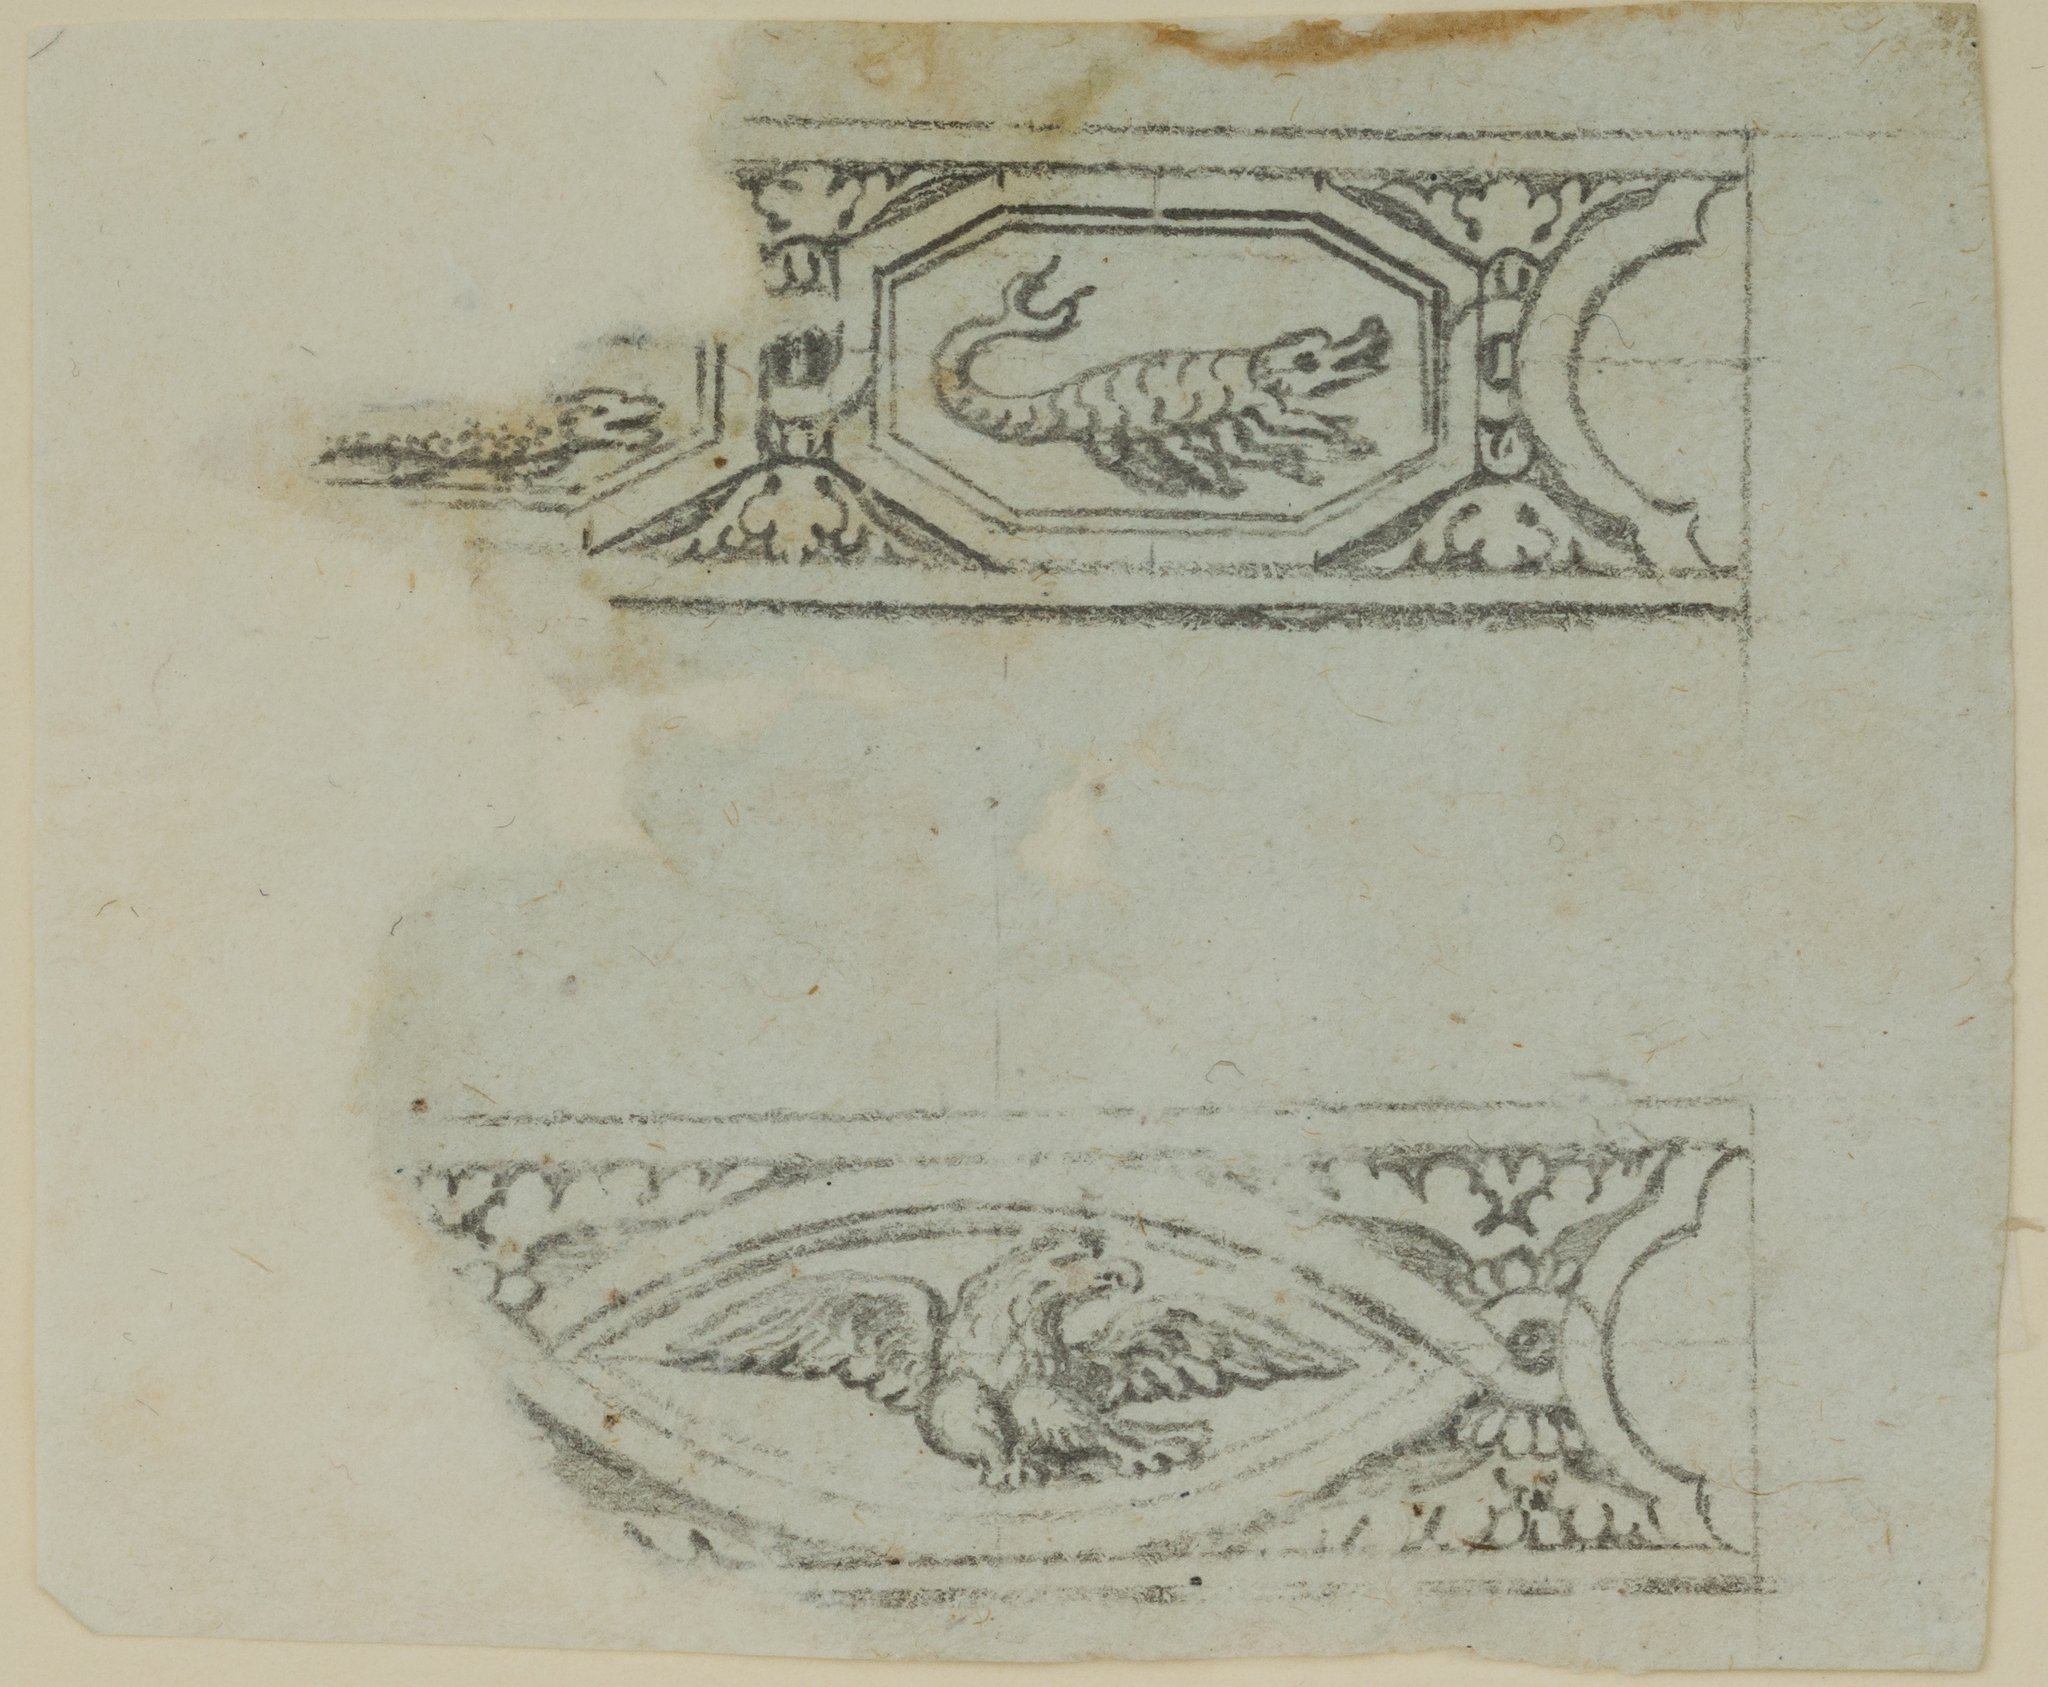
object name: drawing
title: Designs for the Decoration of Firearms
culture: french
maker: nicolas noël boutet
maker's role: designer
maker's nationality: french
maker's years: 1761-1833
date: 1797-1805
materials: ink, paper, pencil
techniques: wash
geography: france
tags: eagles,crocodiles